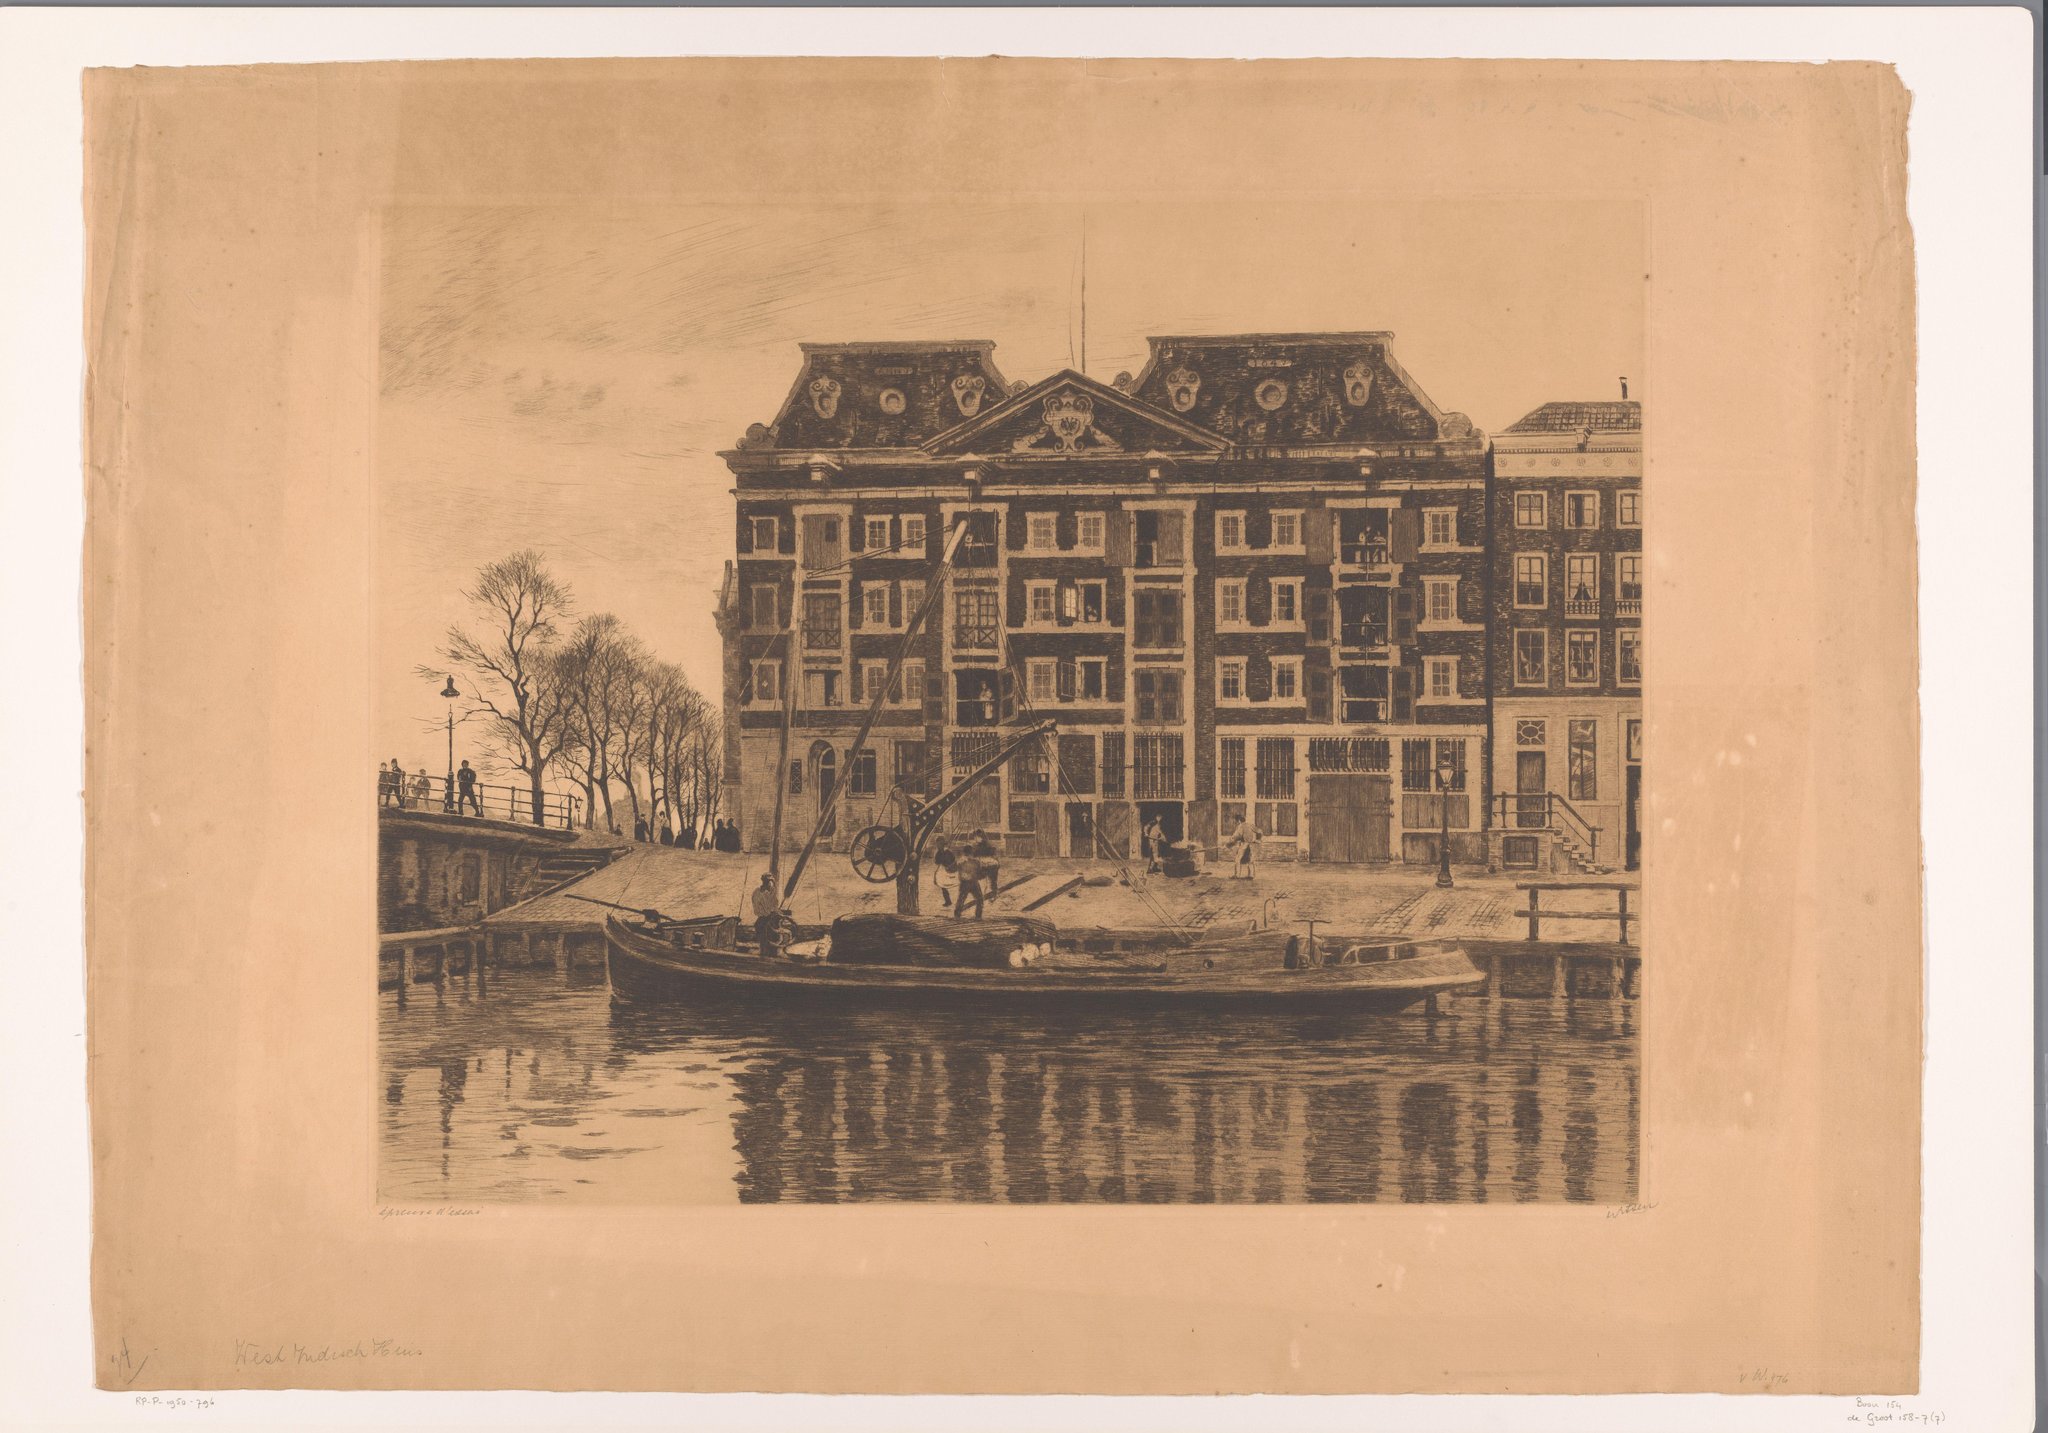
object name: print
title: West-Indisch Huis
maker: willem witsen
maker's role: draughtsman, painter, print maker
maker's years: 1860-1923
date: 1911-1912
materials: paper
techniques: etching, retroussage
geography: netherlands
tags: canal, bridge in city across river, canal, etc., front façade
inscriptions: collector's mark: Lugt 2228